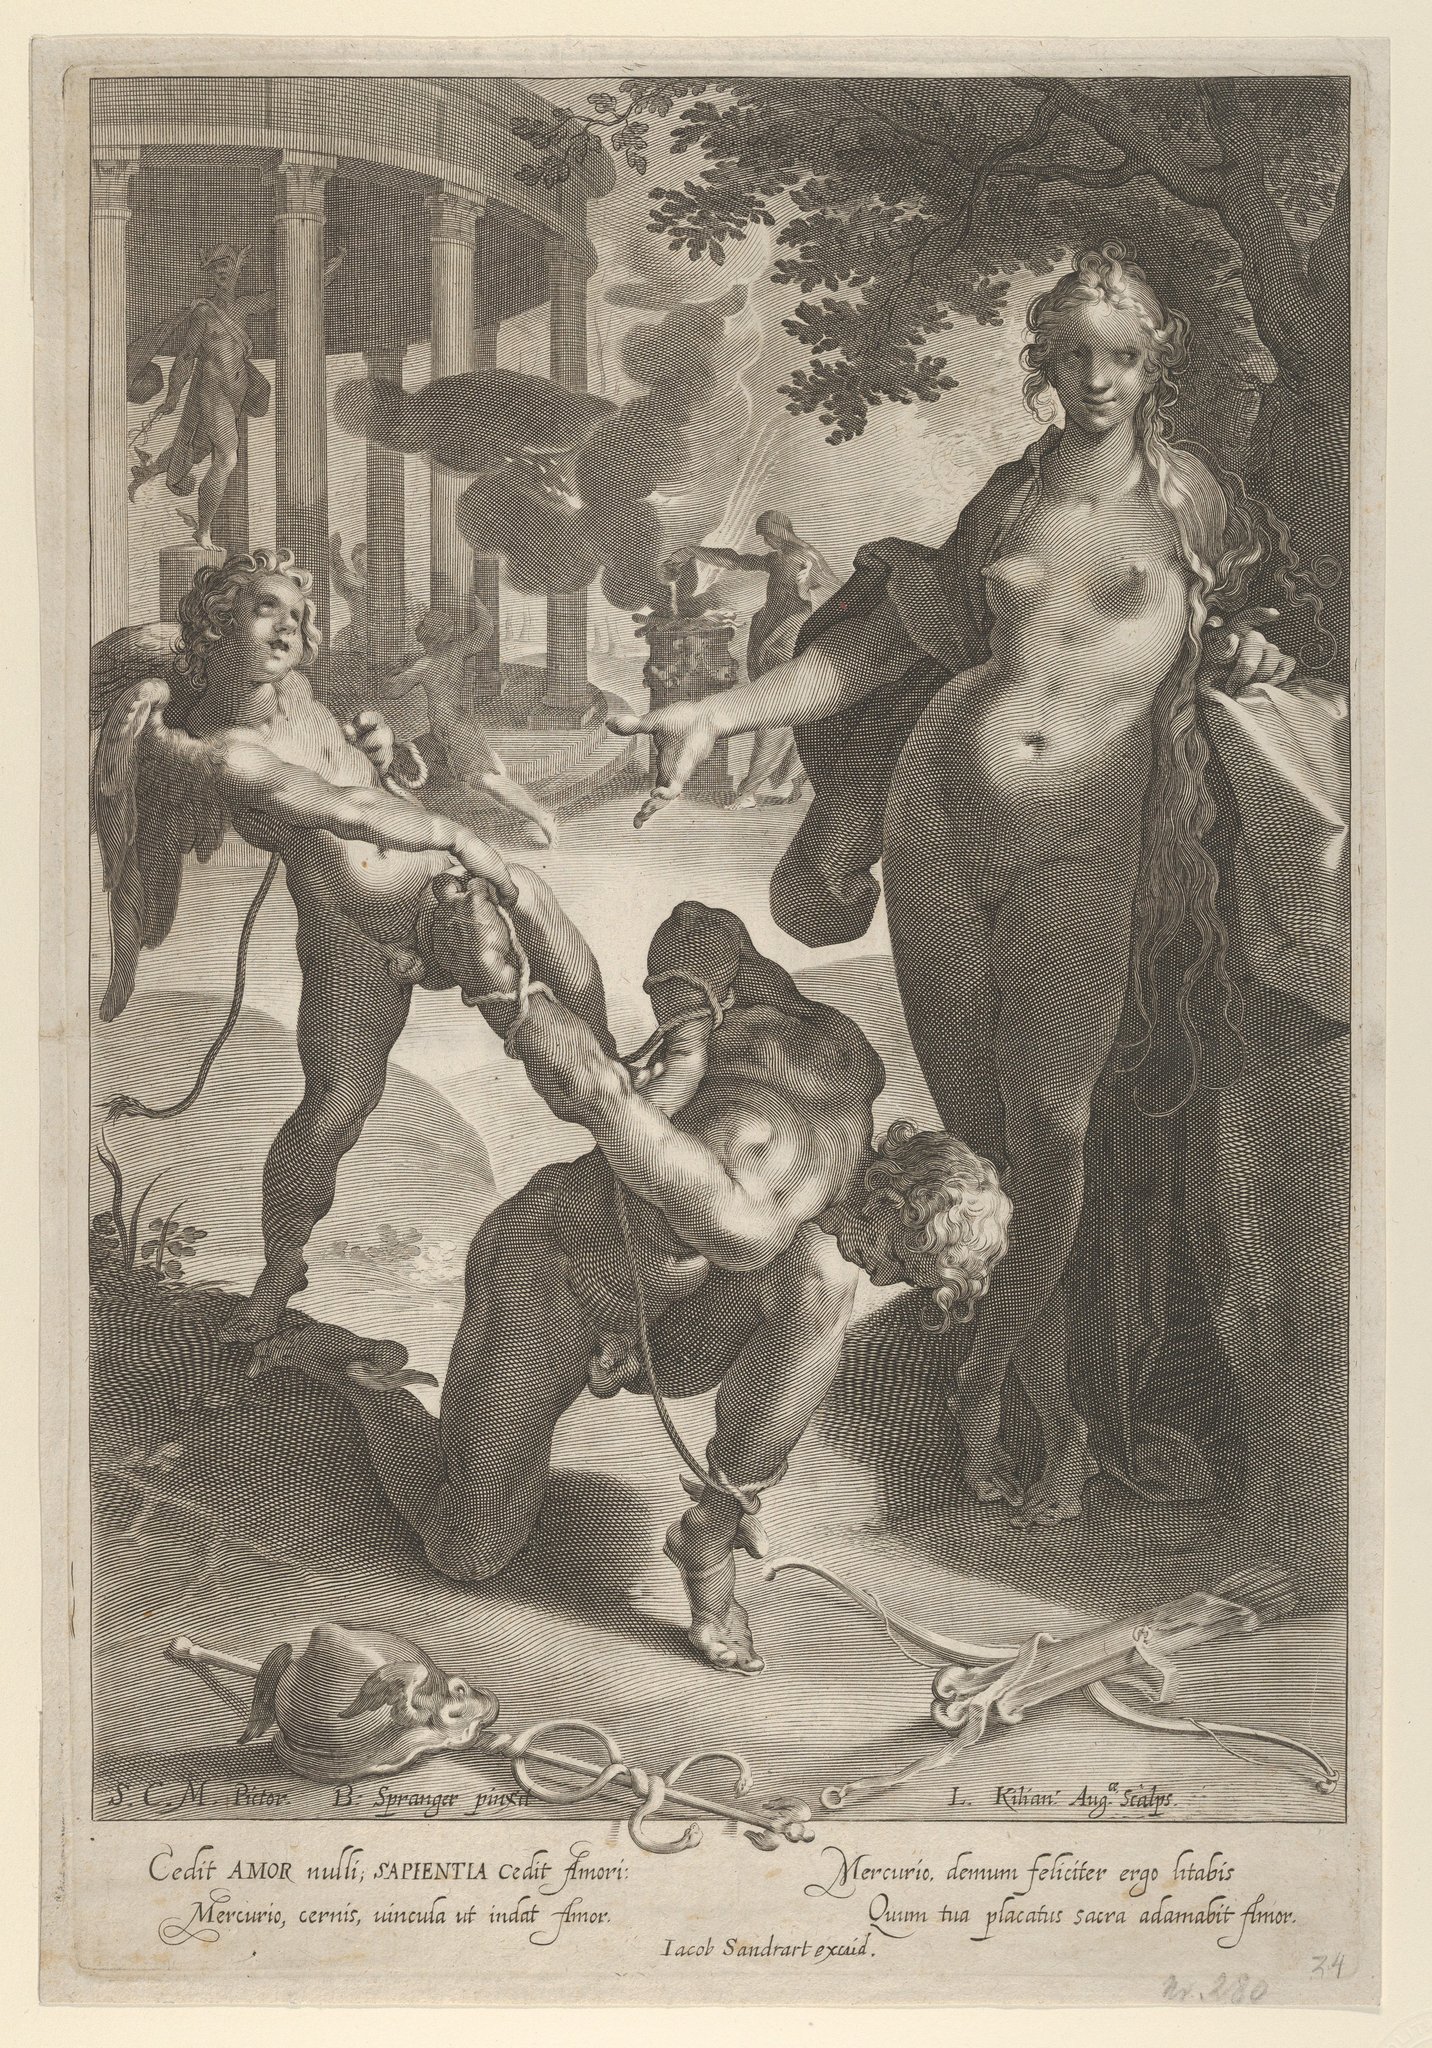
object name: print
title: Venus and Cupid Bind Mercury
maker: lucas kilian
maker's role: artist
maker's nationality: german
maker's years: 1579-1637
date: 1597-1637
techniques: engraving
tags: cupid,mercury,venus